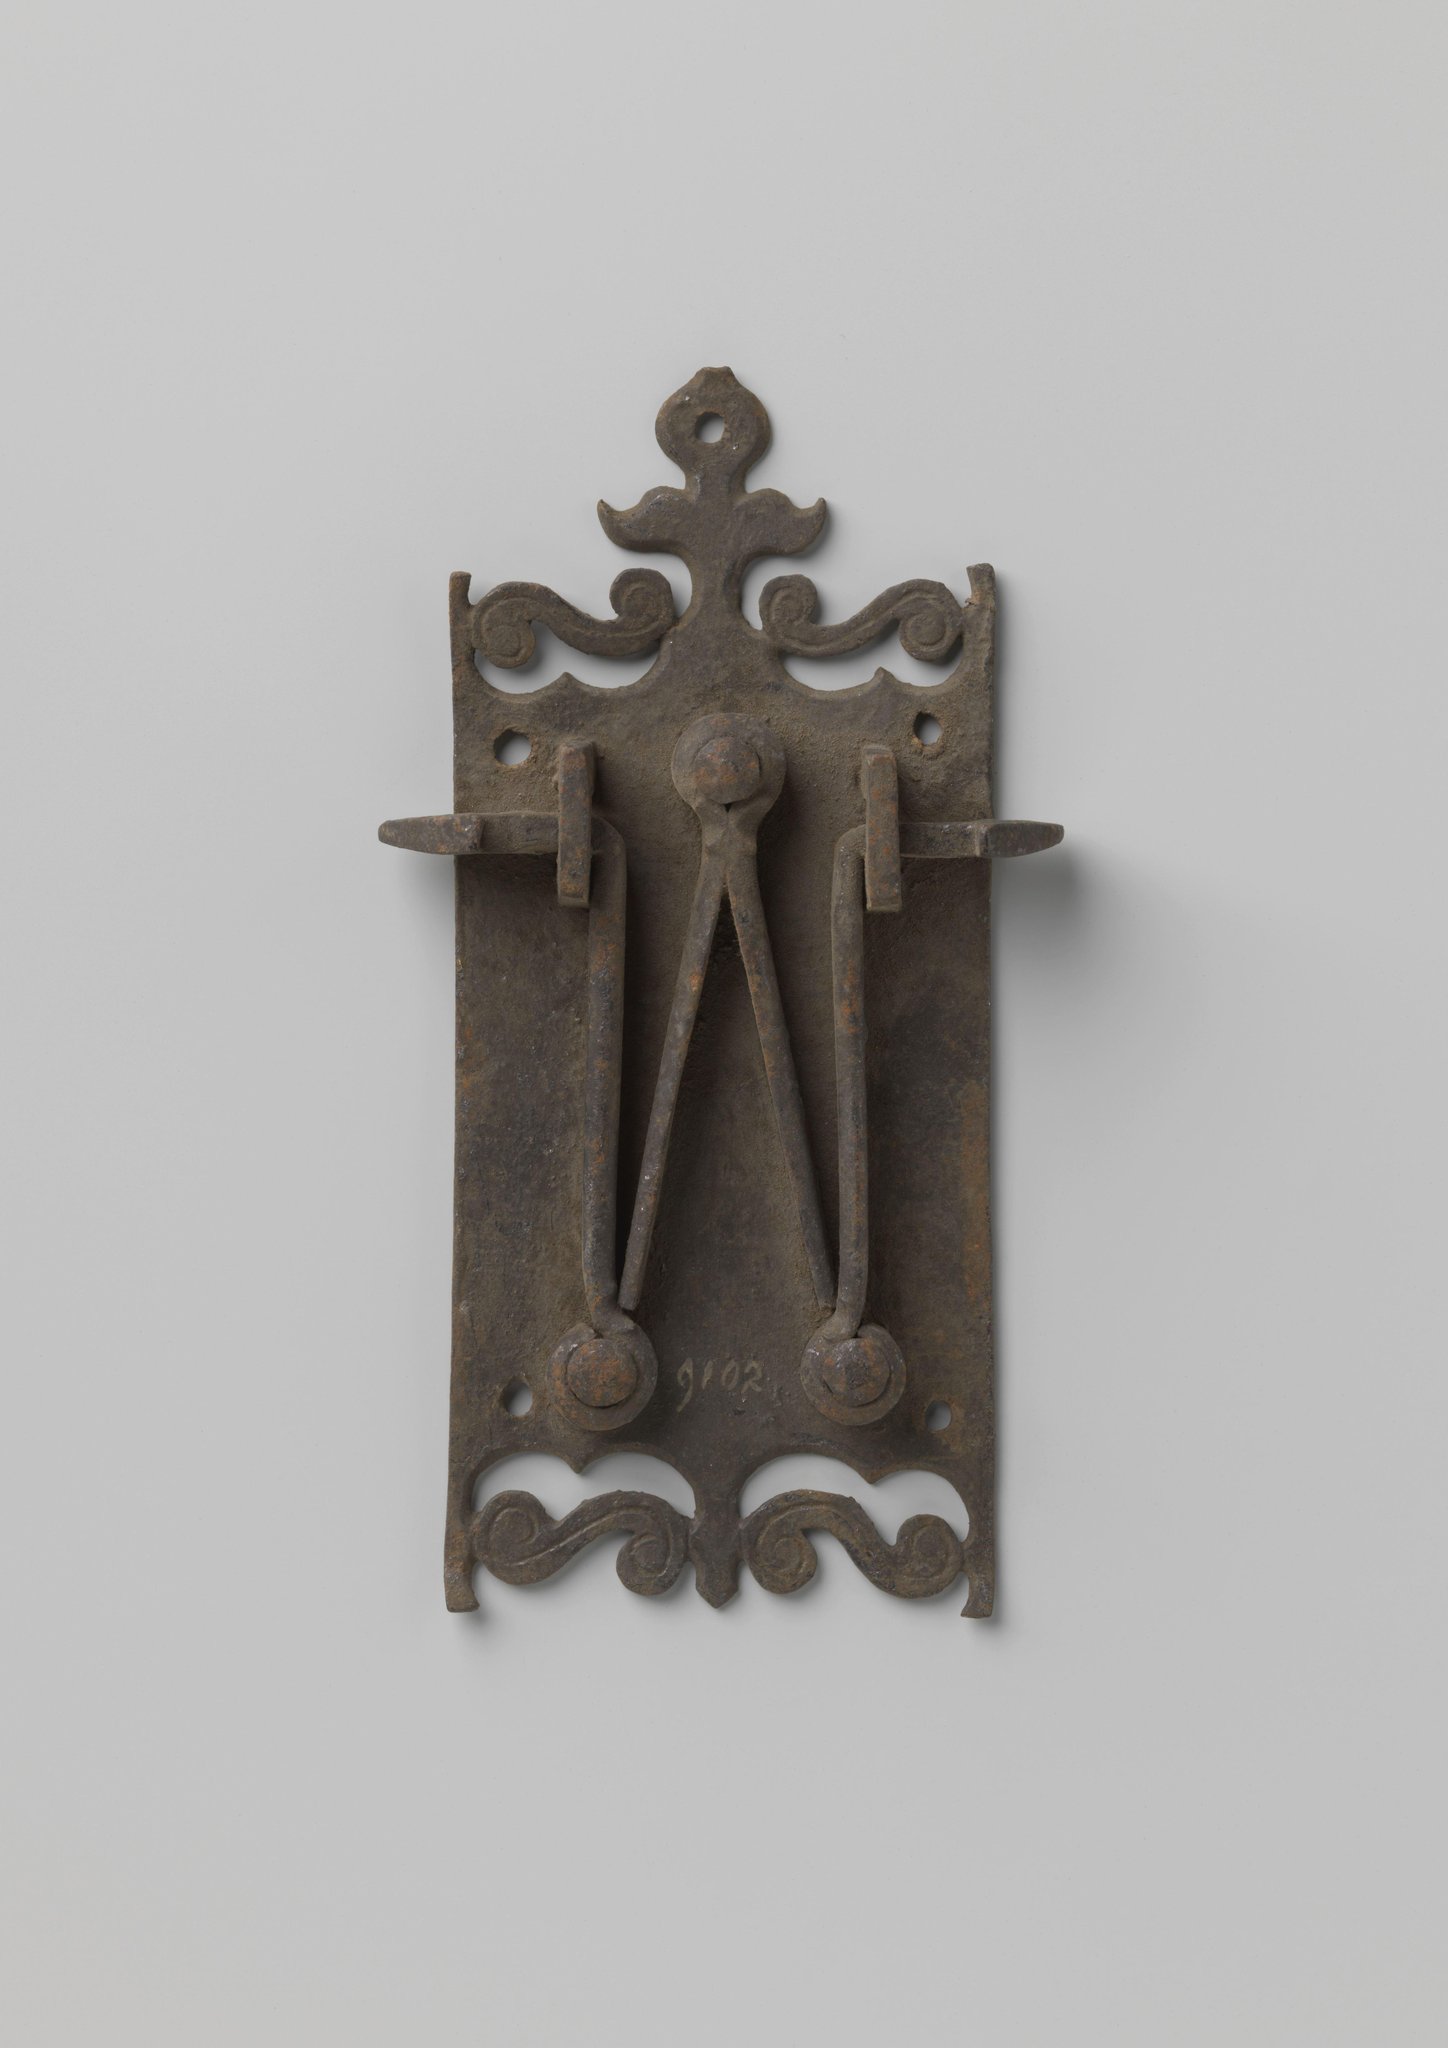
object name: hasp lock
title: Knipsot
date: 1400-1950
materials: iron